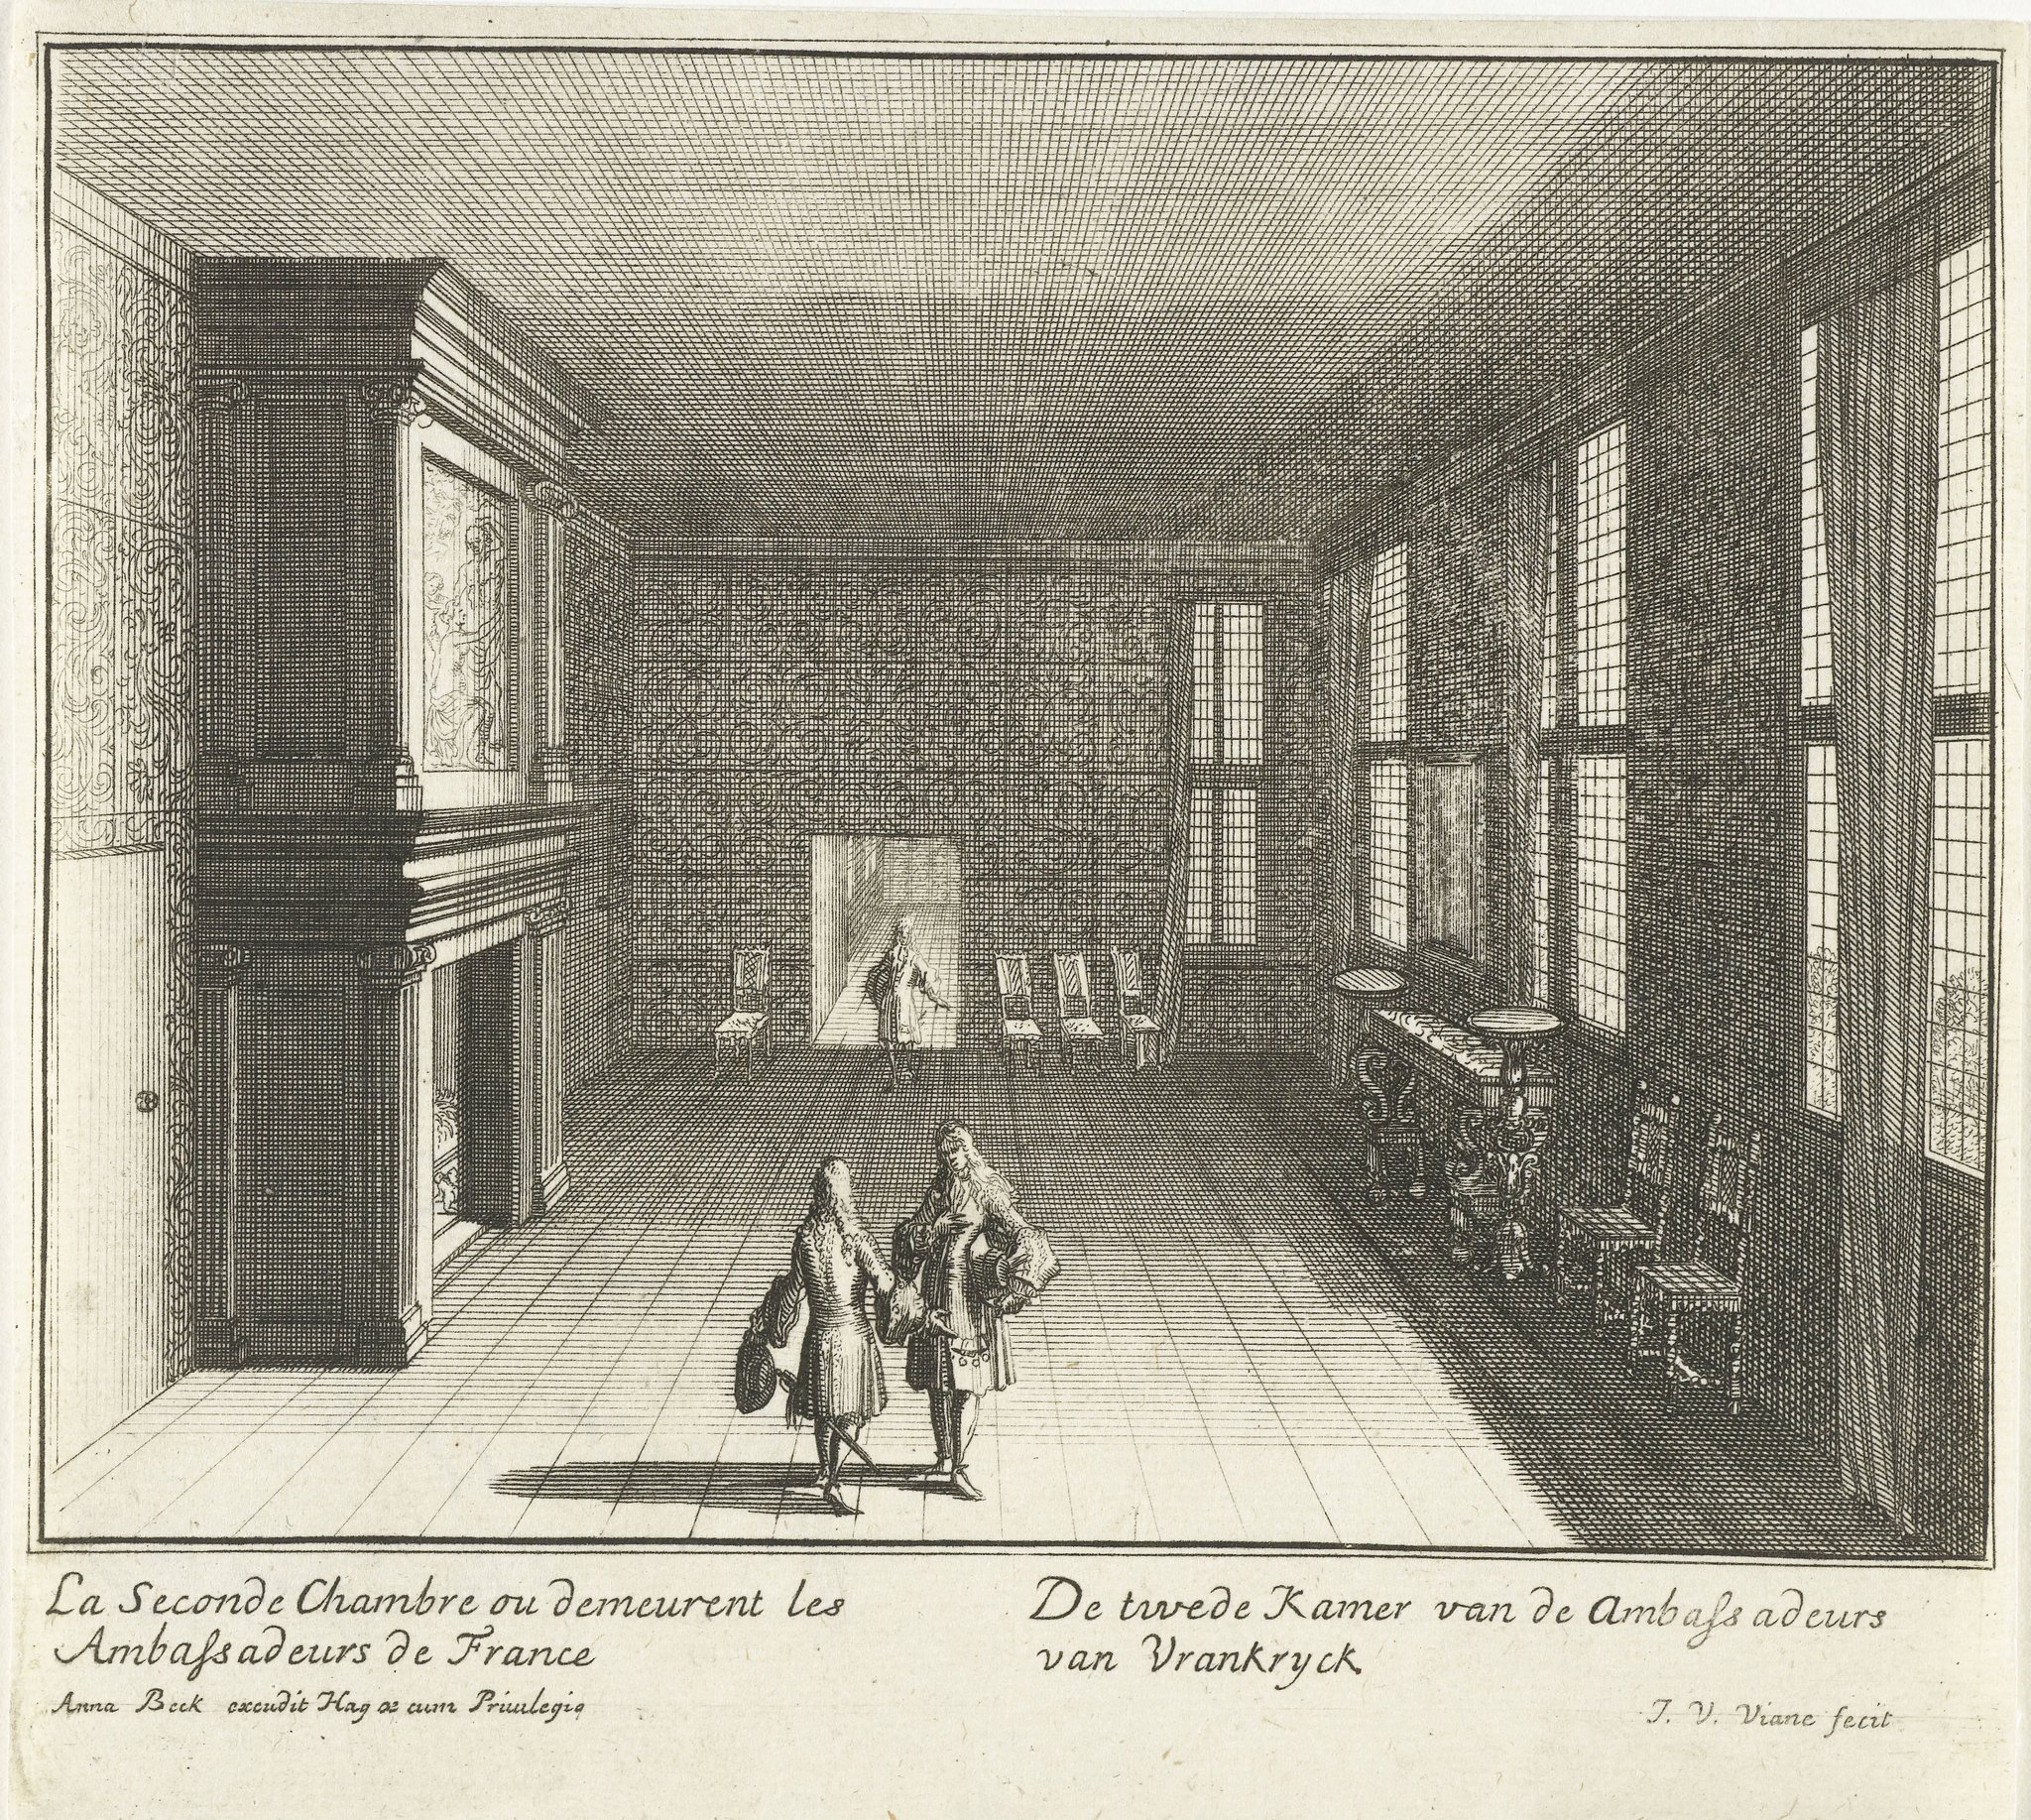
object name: print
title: De twede Kamer van de Ambassadeurs van Vrankryck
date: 1697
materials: paper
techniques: etching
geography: northern netherlands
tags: palace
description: De tweede kamer van de Franse ambassadeurs in het Huis ter Nieuburch in Rijswijk. In het onderschrift de twee titels in het Frans en Nederlands. Onderdeel (prent 9) van de serie van zestien kleinere prenten over het Huis ter Nieuburch in Rijswijk en de daar gehouden vredesonderhandelingen resulterend in de Vrede van Rijswijk gesloten op 20 september 1697.